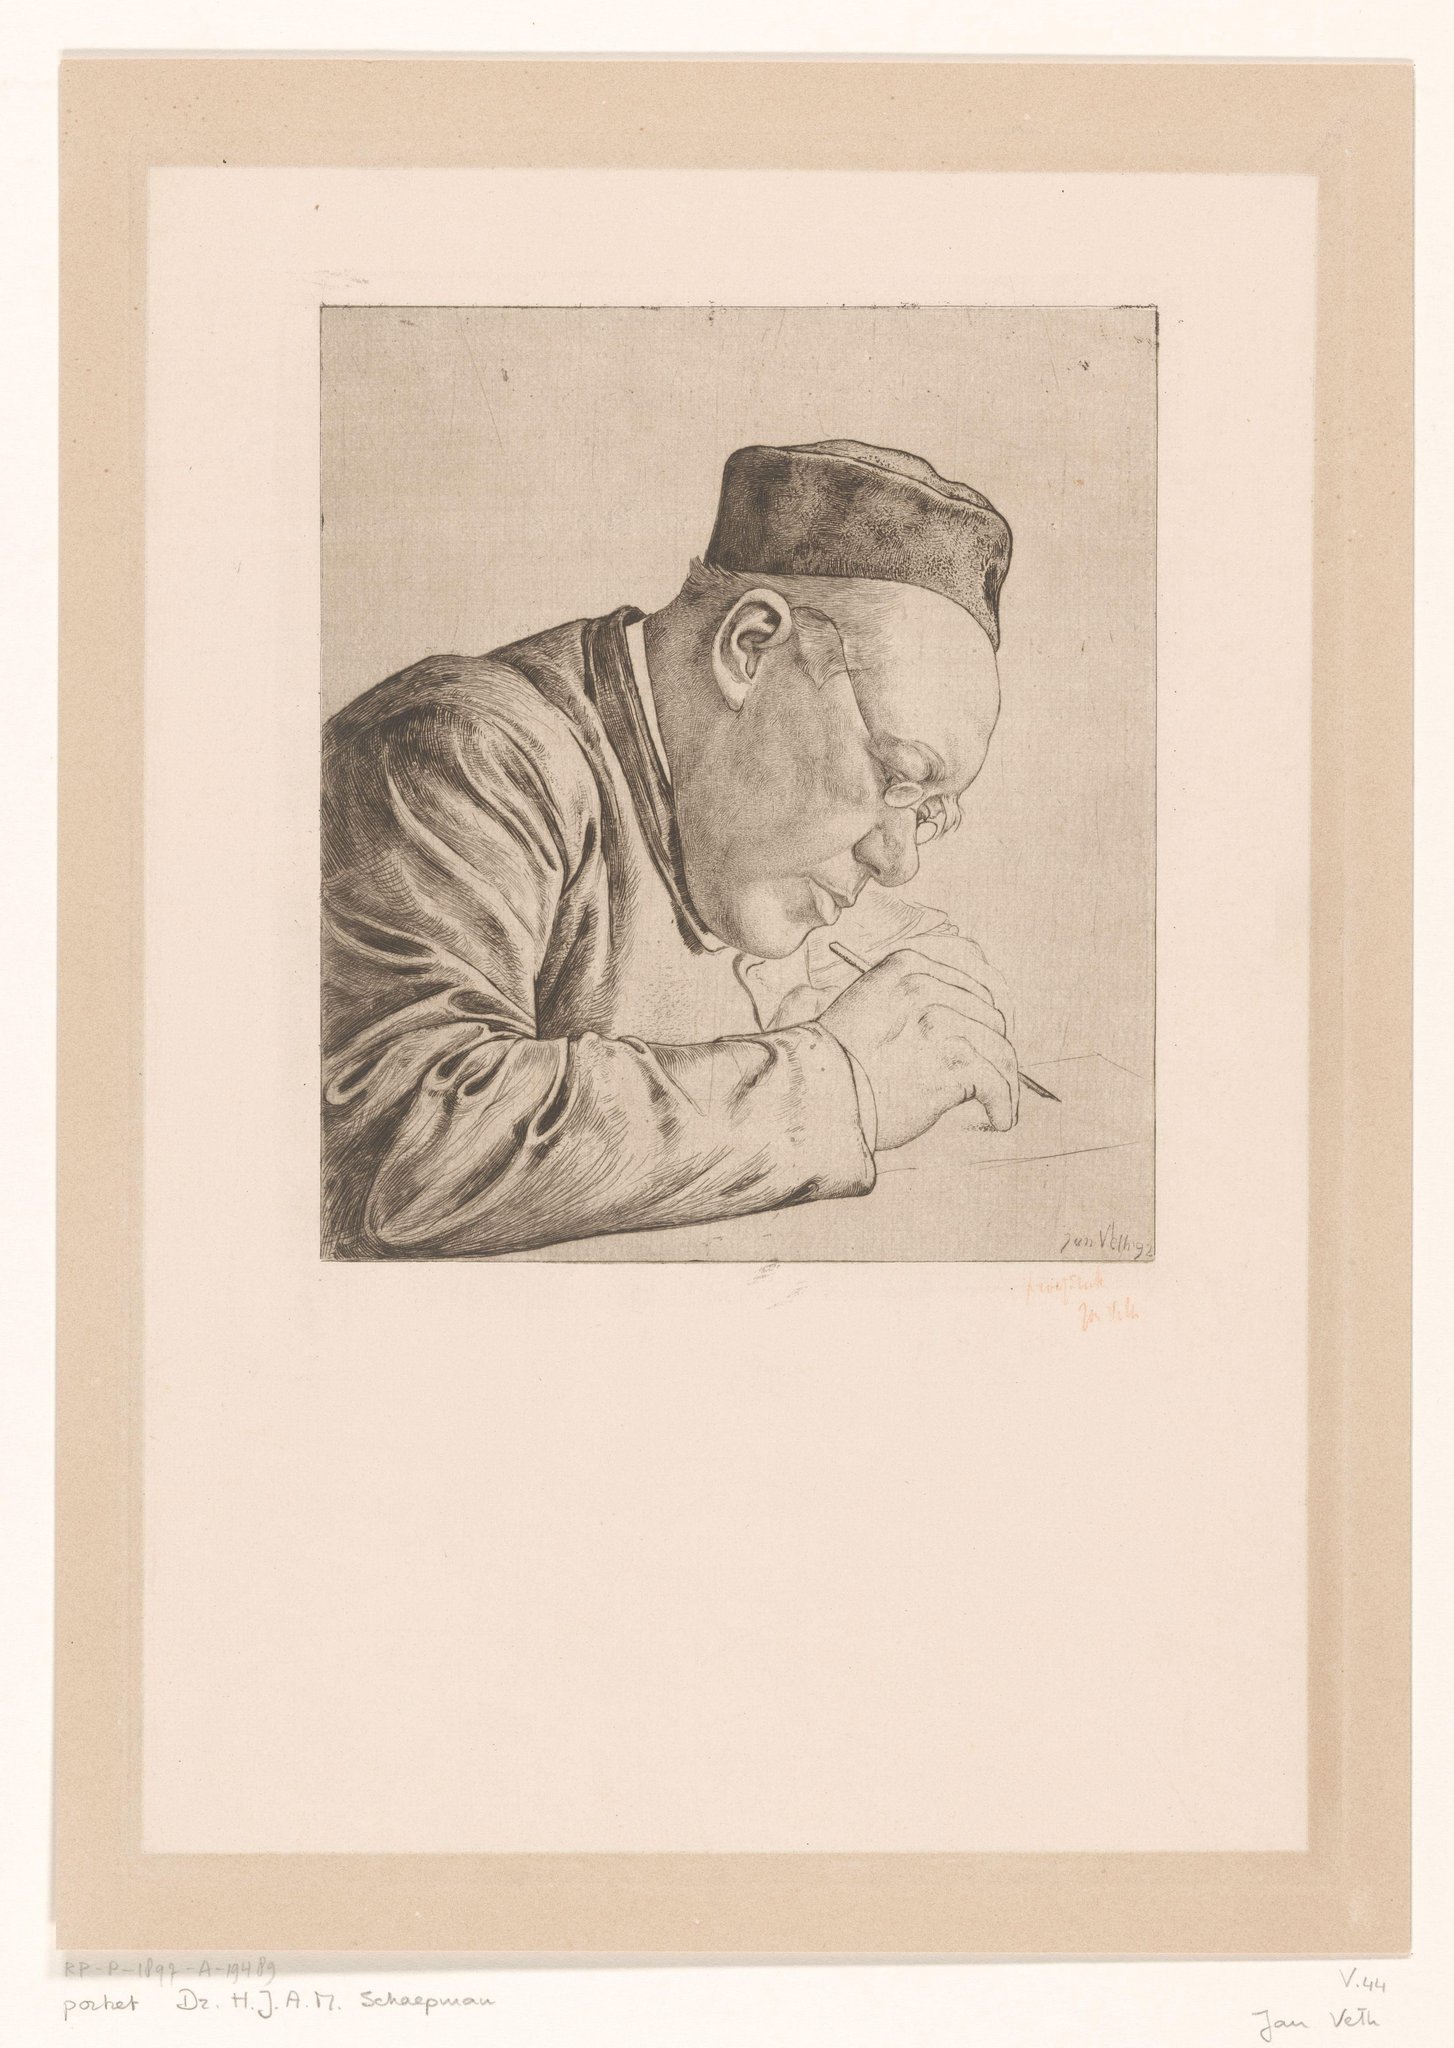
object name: print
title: Portret van Herman Schaepman, schrijvend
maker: jan veth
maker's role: designer, draughtsman, painter, print maker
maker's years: 1864-1925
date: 1892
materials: paper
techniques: etching, intaglio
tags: rome, priest, herman johannes aloysius maria schaepman, historical persons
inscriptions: collector's mark: Lugt 2228